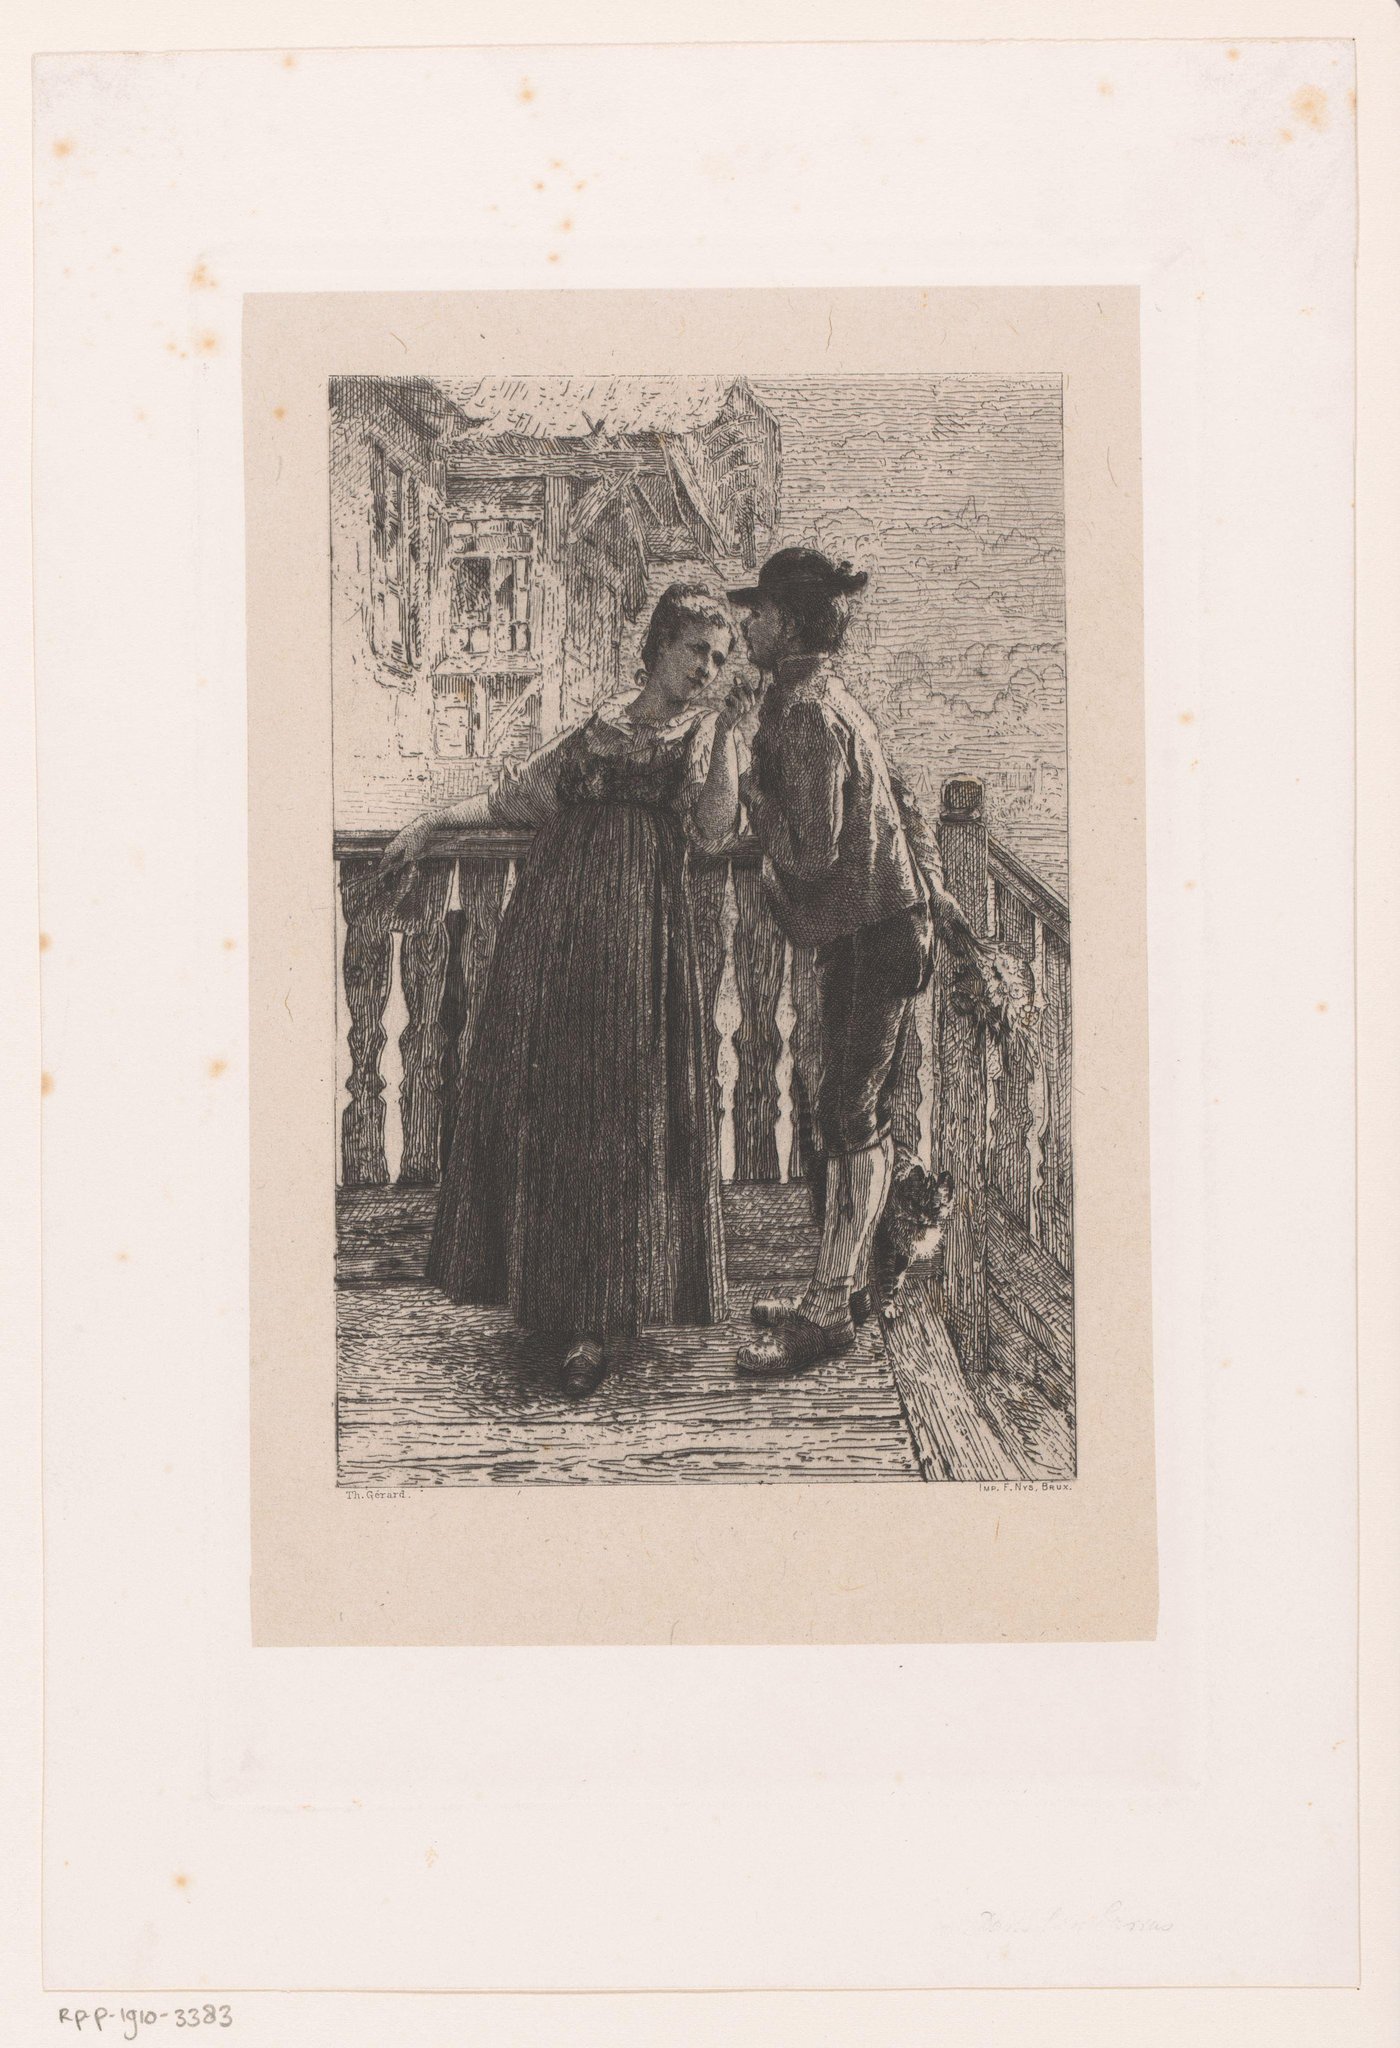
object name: print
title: Jong liefdeskoppel op een veranda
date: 1875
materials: paper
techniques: etching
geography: brussels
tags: flowers, cat, couple of lovers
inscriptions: collector's mark: Lugt 2228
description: Prent verschenen in: Album du journal des Beaux-Arts, dix eaux-fortes inédites. Brussel, Parijs, Leipzig: S.n., 1875.